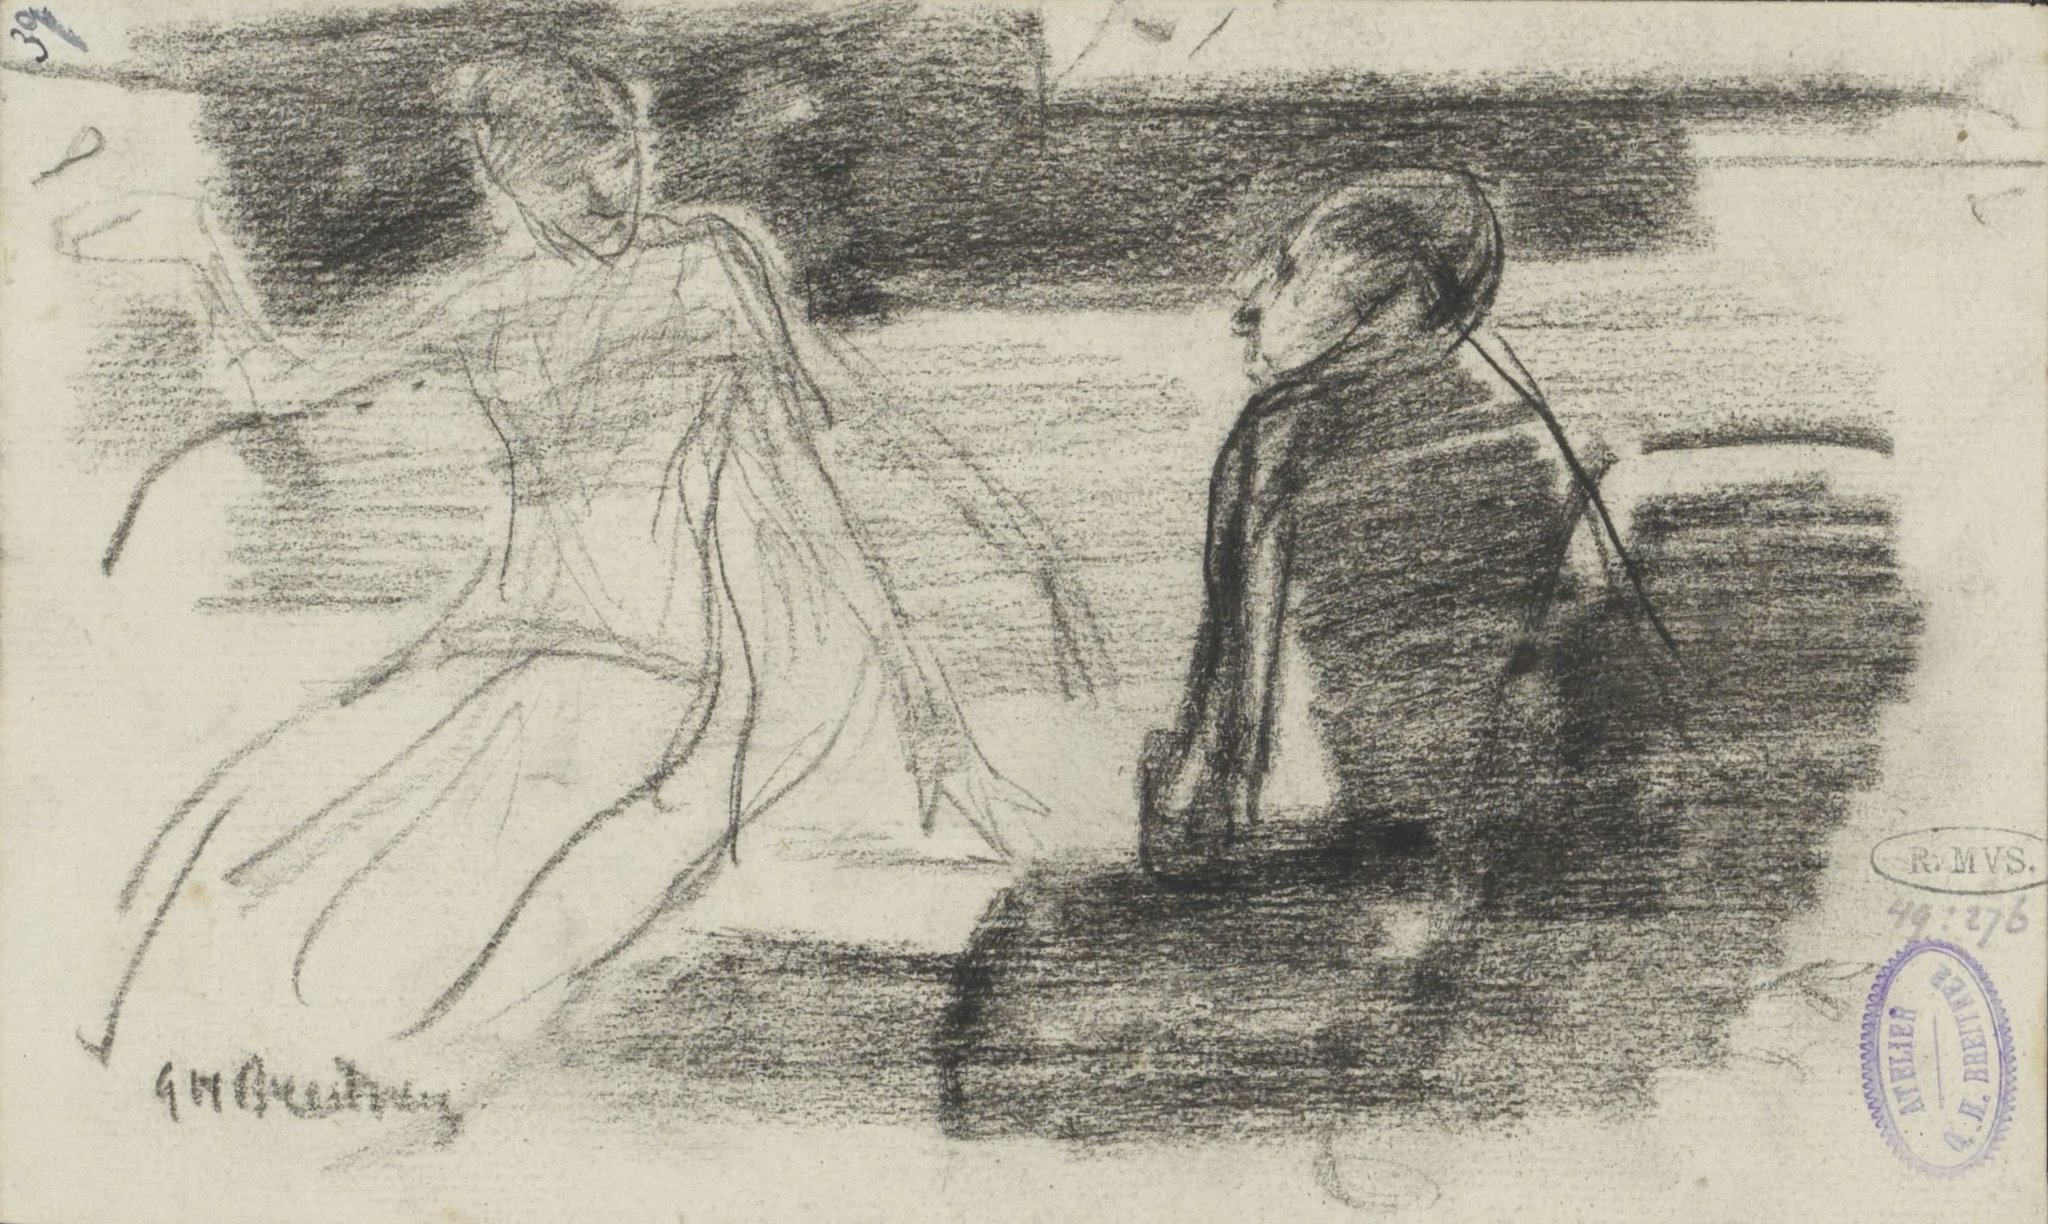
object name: drawing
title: Zittende vrouw en man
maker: george hendrik breitner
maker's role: draughtsman, painter, print maker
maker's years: 1857-1923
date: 1873-1923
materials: chalk, paper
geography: the hague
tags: sitting on an elevation, couch, sofa, settee, sitting on an elevation - aa - female human figure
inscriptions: workshop stamp: Lugt 291d, collector's mark: Lugt 2228, signature: ‘G H Breitner’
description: Ze zitten tegenover elkaar op banken. De vrouw leunt met haar rechterarm op de rugleuning.